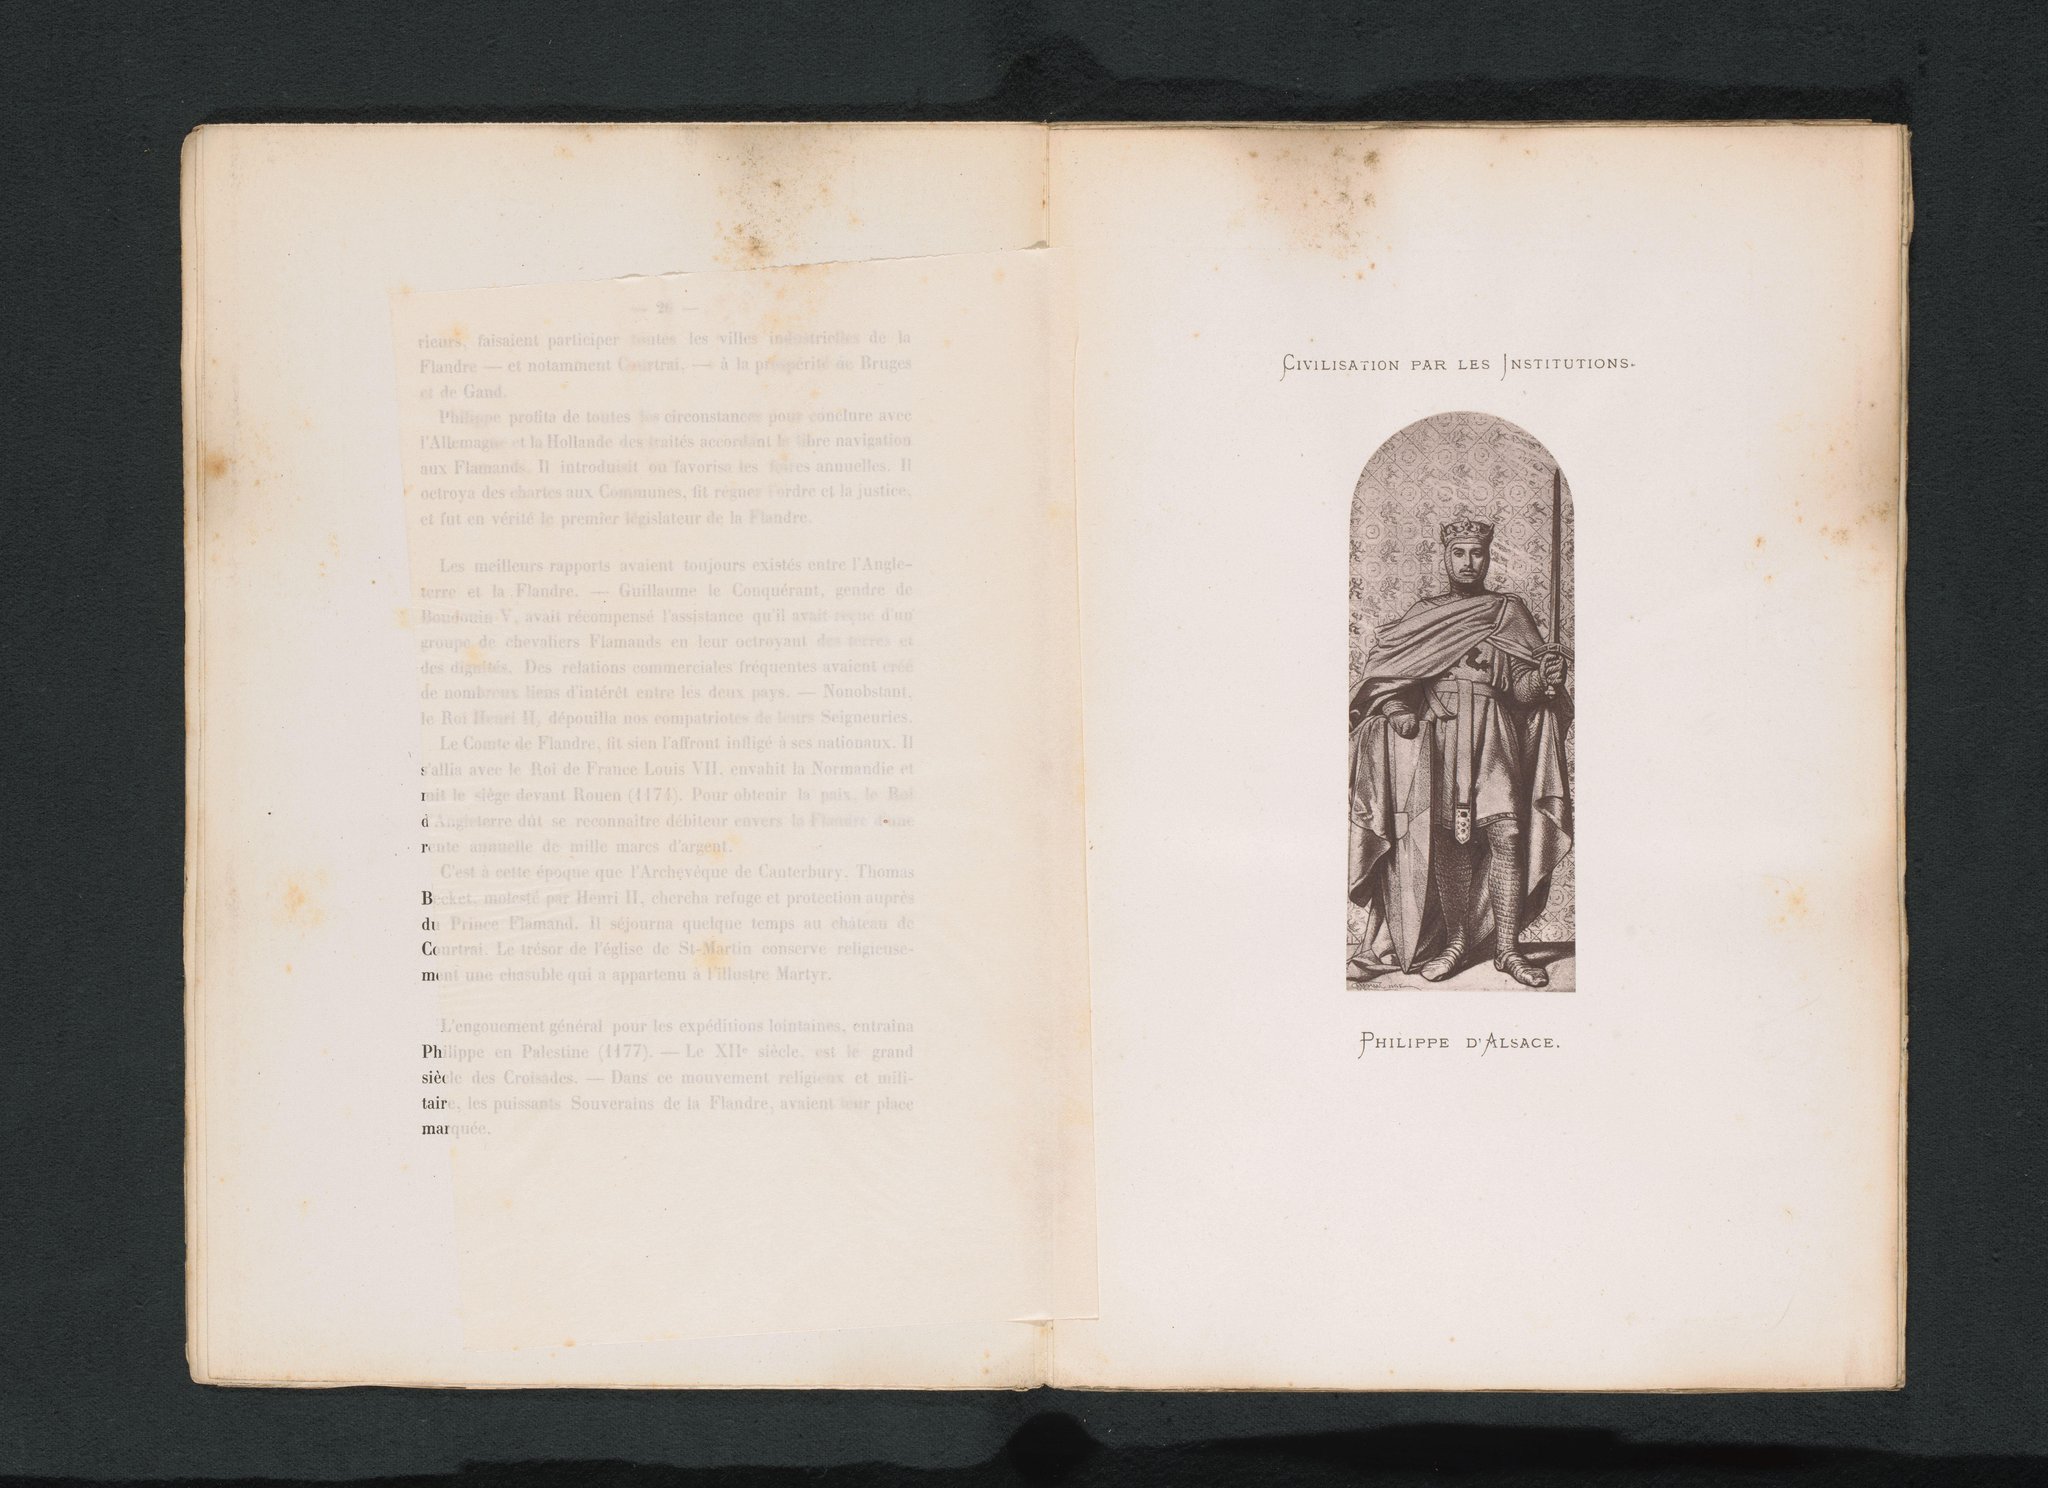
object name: page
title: Reproductie van een tekening naar een muurschildering in de Schepenzaal in het Stadhuis van Kortrijk, voorstellende Filips van de Elzas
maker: Anonymous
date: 1871-1876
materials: paper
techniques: woodburytype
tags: earl, knight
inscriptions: inscription: ‘Civilisation par les Institutions.’